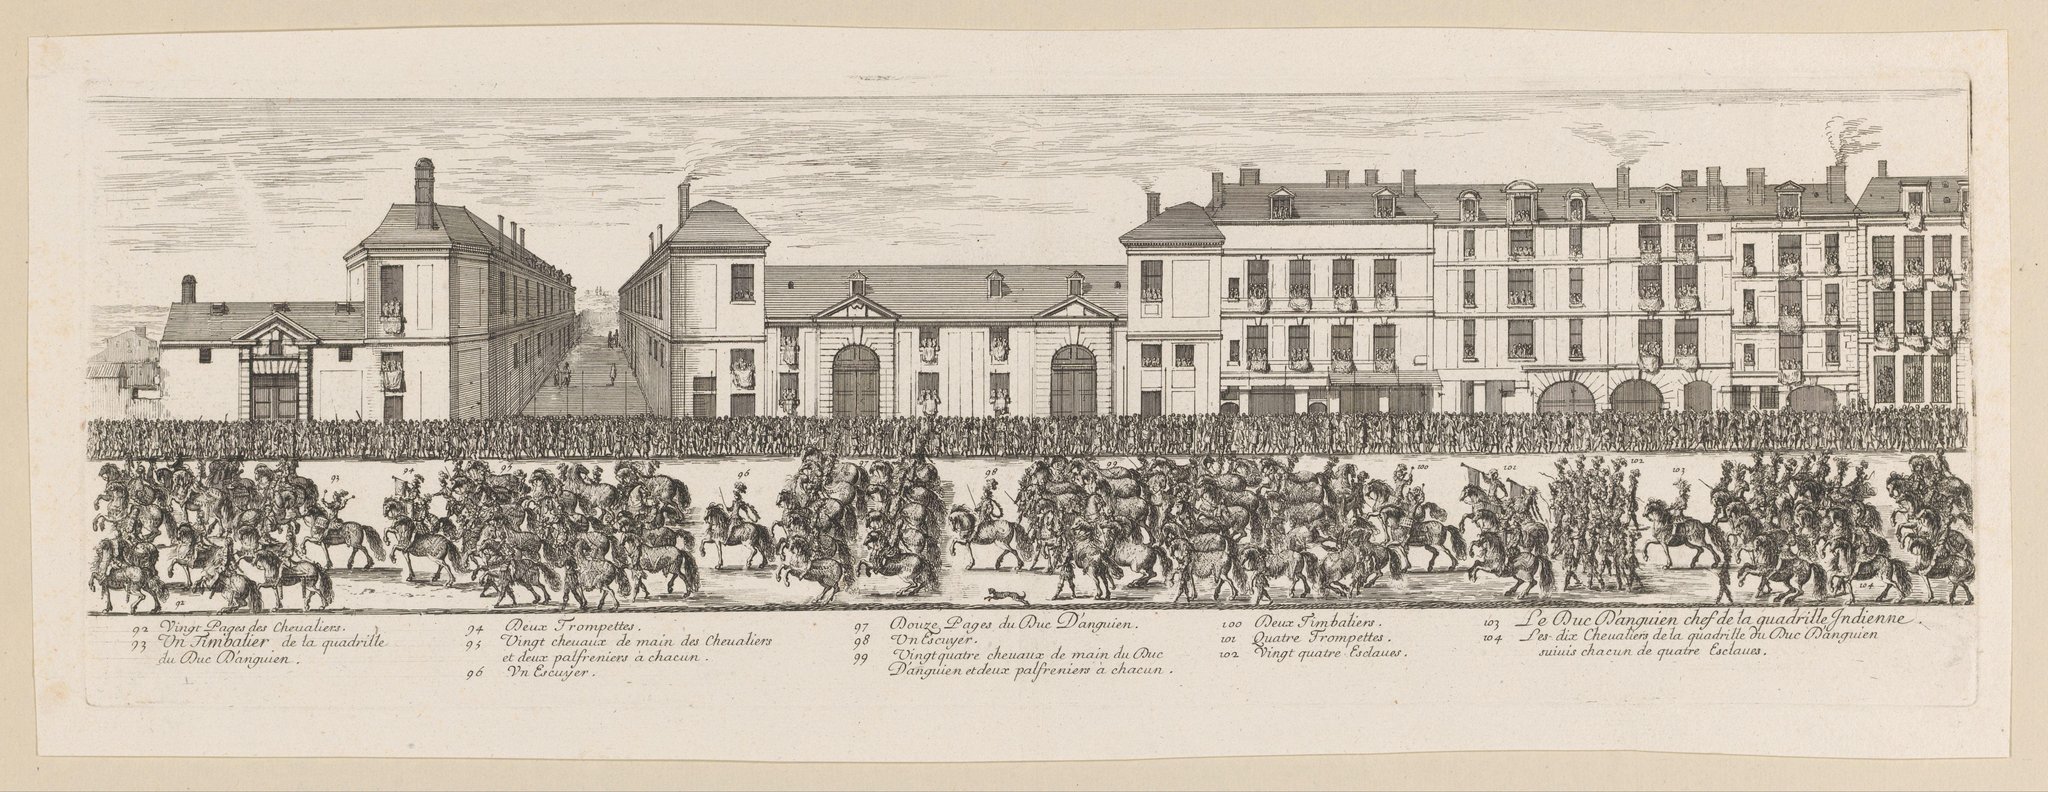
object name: print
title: Toernooien gegeven door Lodewijk XIV in 1662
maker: israël silvestre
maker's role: draughtsman, print maker, publisher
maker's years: 1621-1691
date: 1662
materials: paper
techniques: etching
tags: tournament, military parade, pageant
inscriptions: collector's mark: Lugt 240